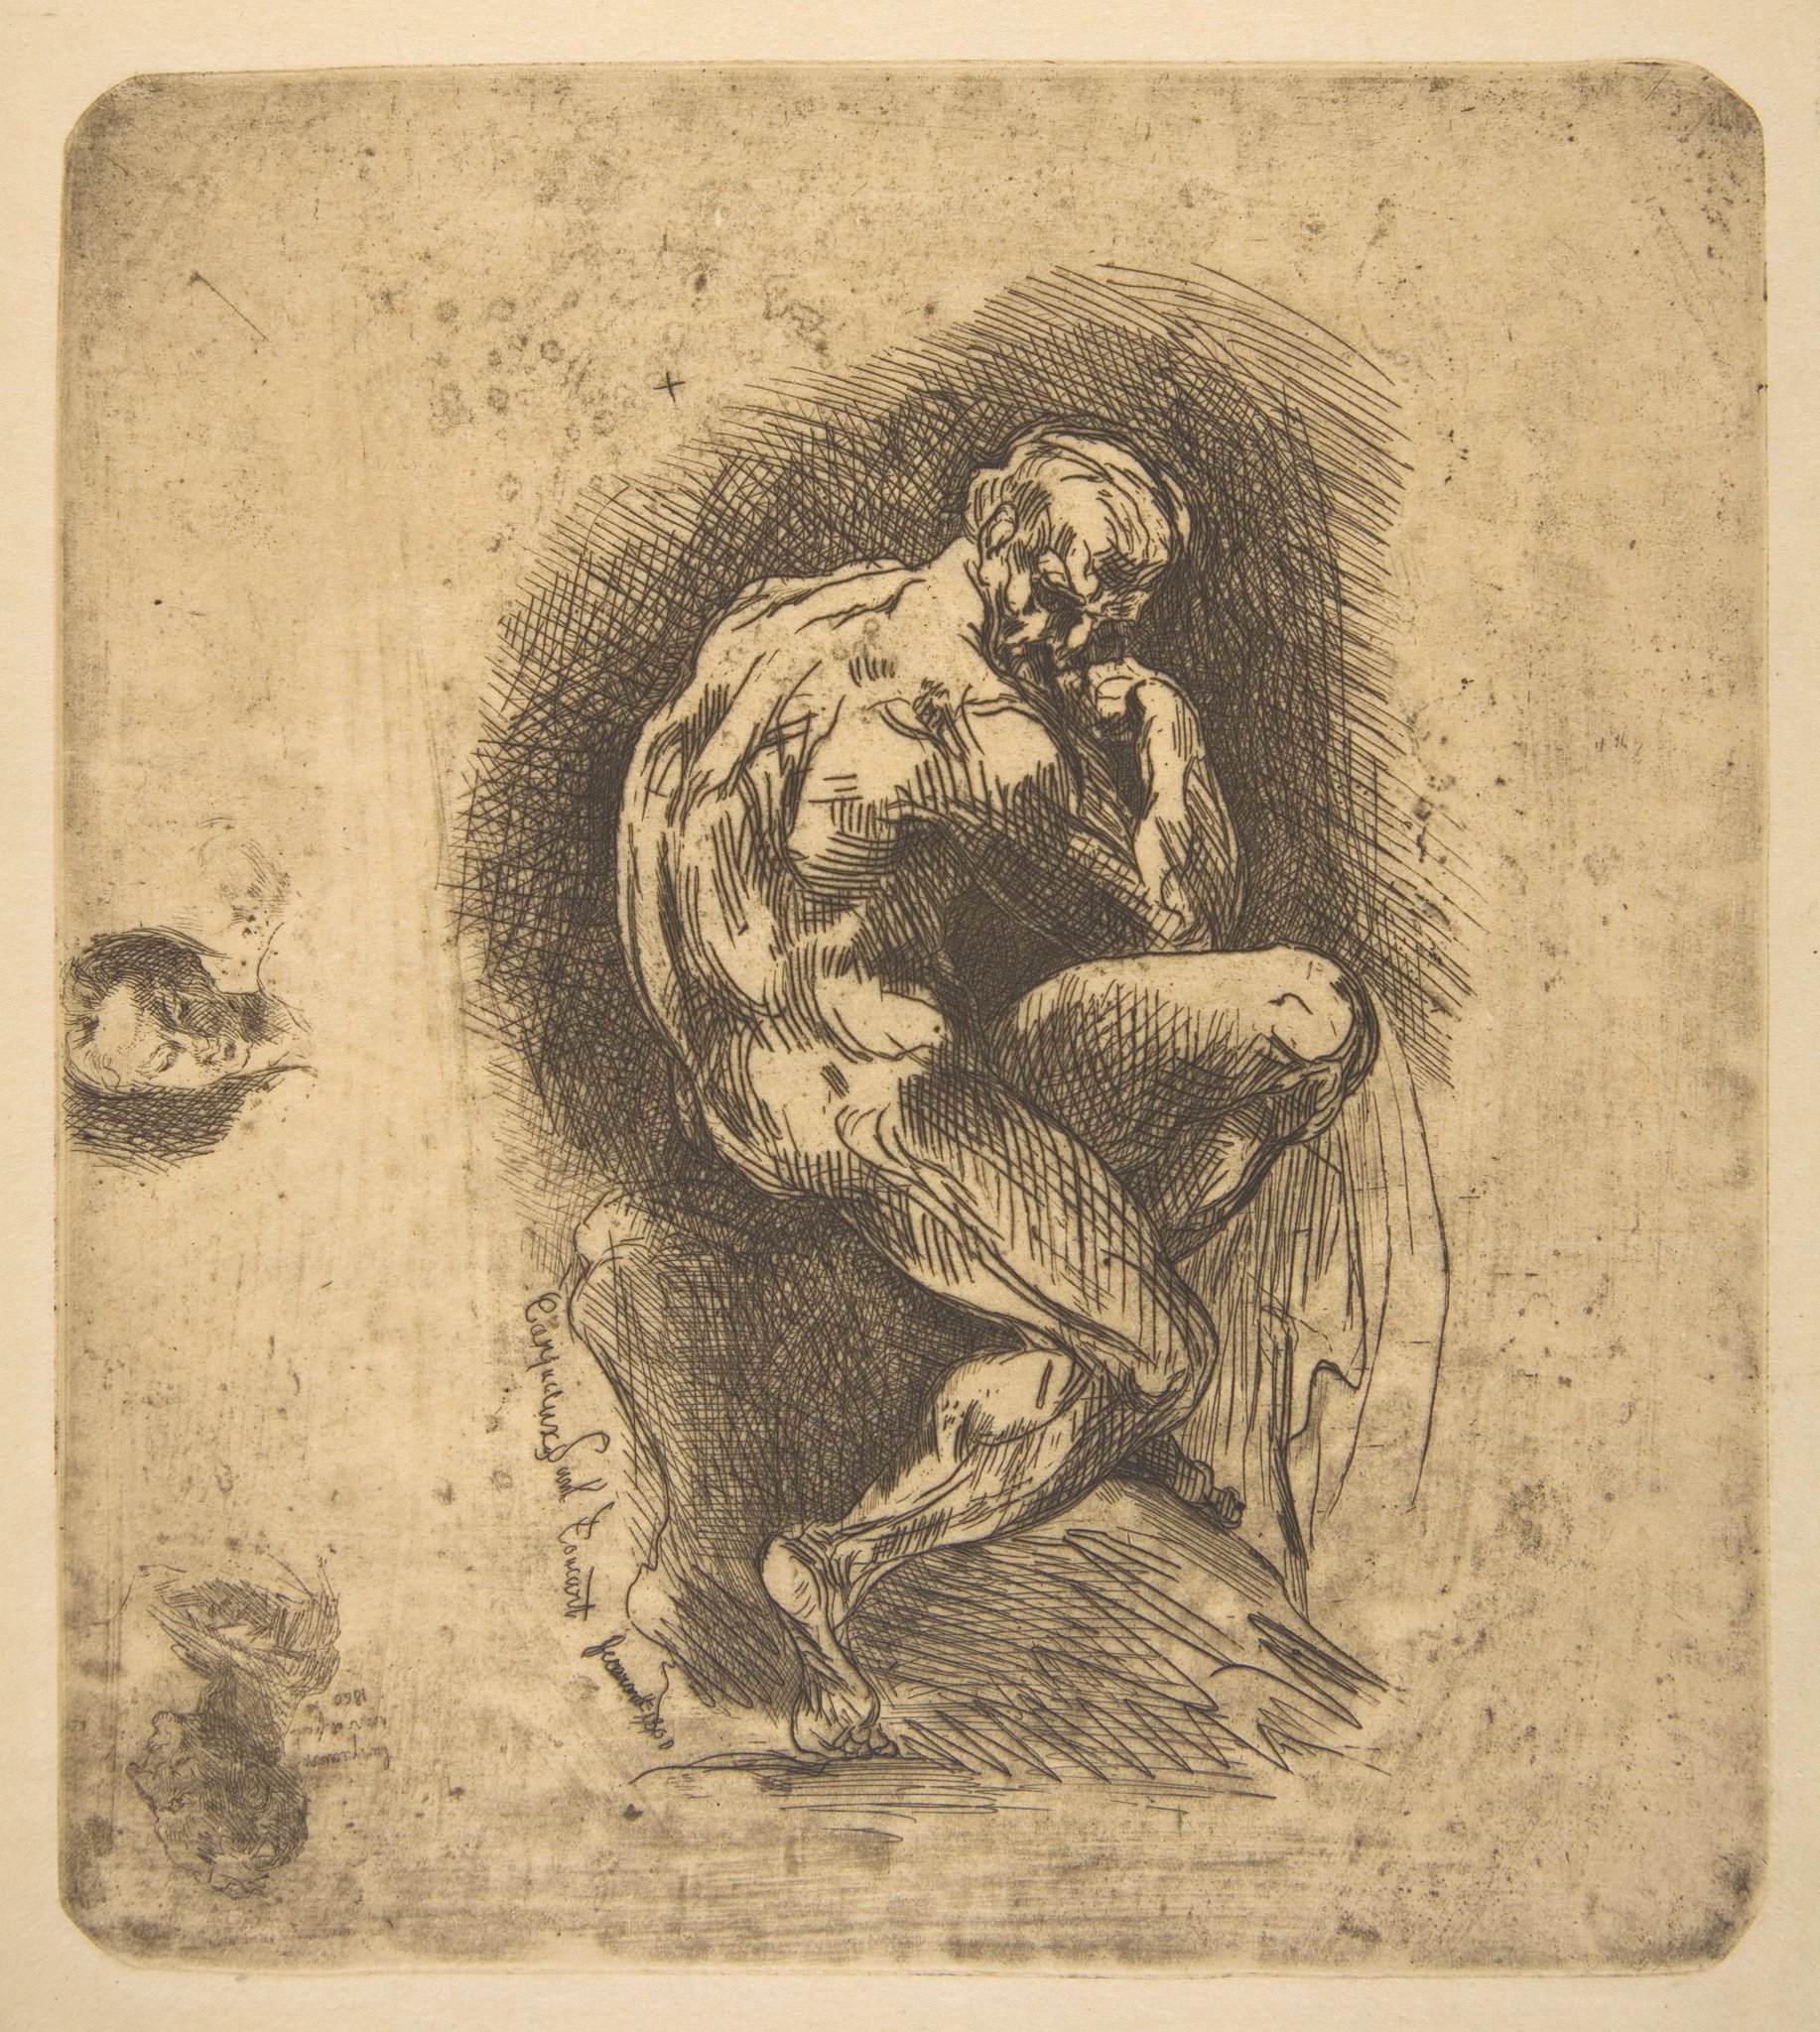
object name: print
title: Ugolino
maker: jean-baptiste carpeaux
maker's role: artist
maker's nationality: french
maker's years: 1827-1875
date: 1860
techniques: etching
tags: male nudes